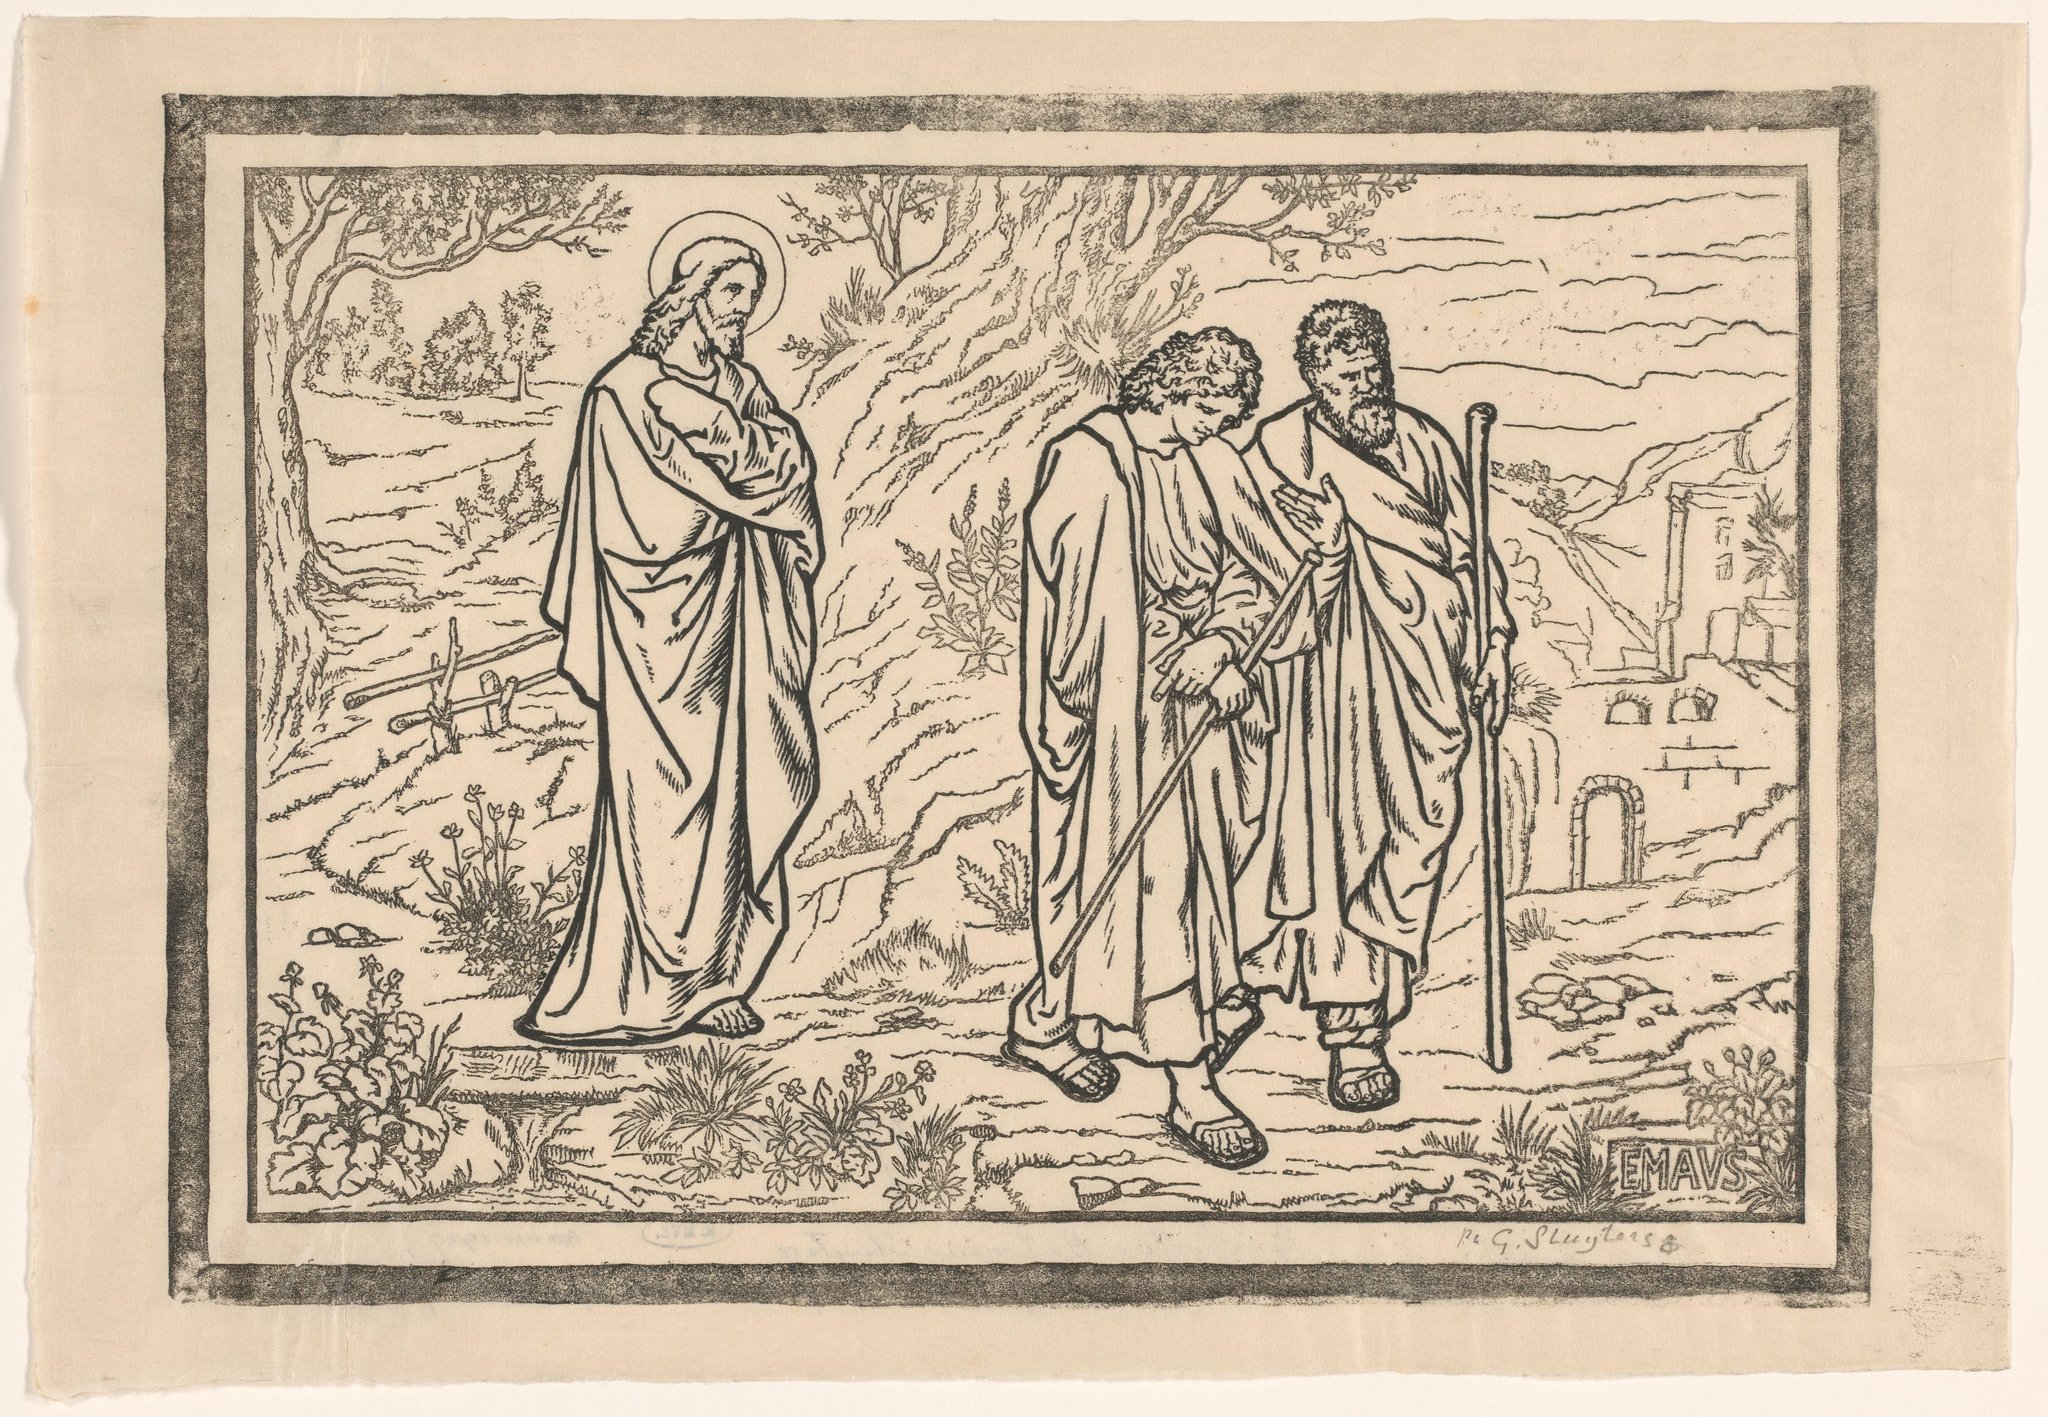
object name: print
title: Emmaüsgangers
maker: gijsbertus antonius sluijters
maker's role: print maker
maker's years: 1847-1927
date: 1857-1927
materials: paper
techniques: woodcut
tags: the journey to emmaus: two disciples (cleopas and peter) under way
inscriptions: collector's mark: Lugt 2228, collector's mark: Lugt 2760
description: Kleopas en Petrus lopen met wandelstokken over een landweg. Achter hen staat Christus.